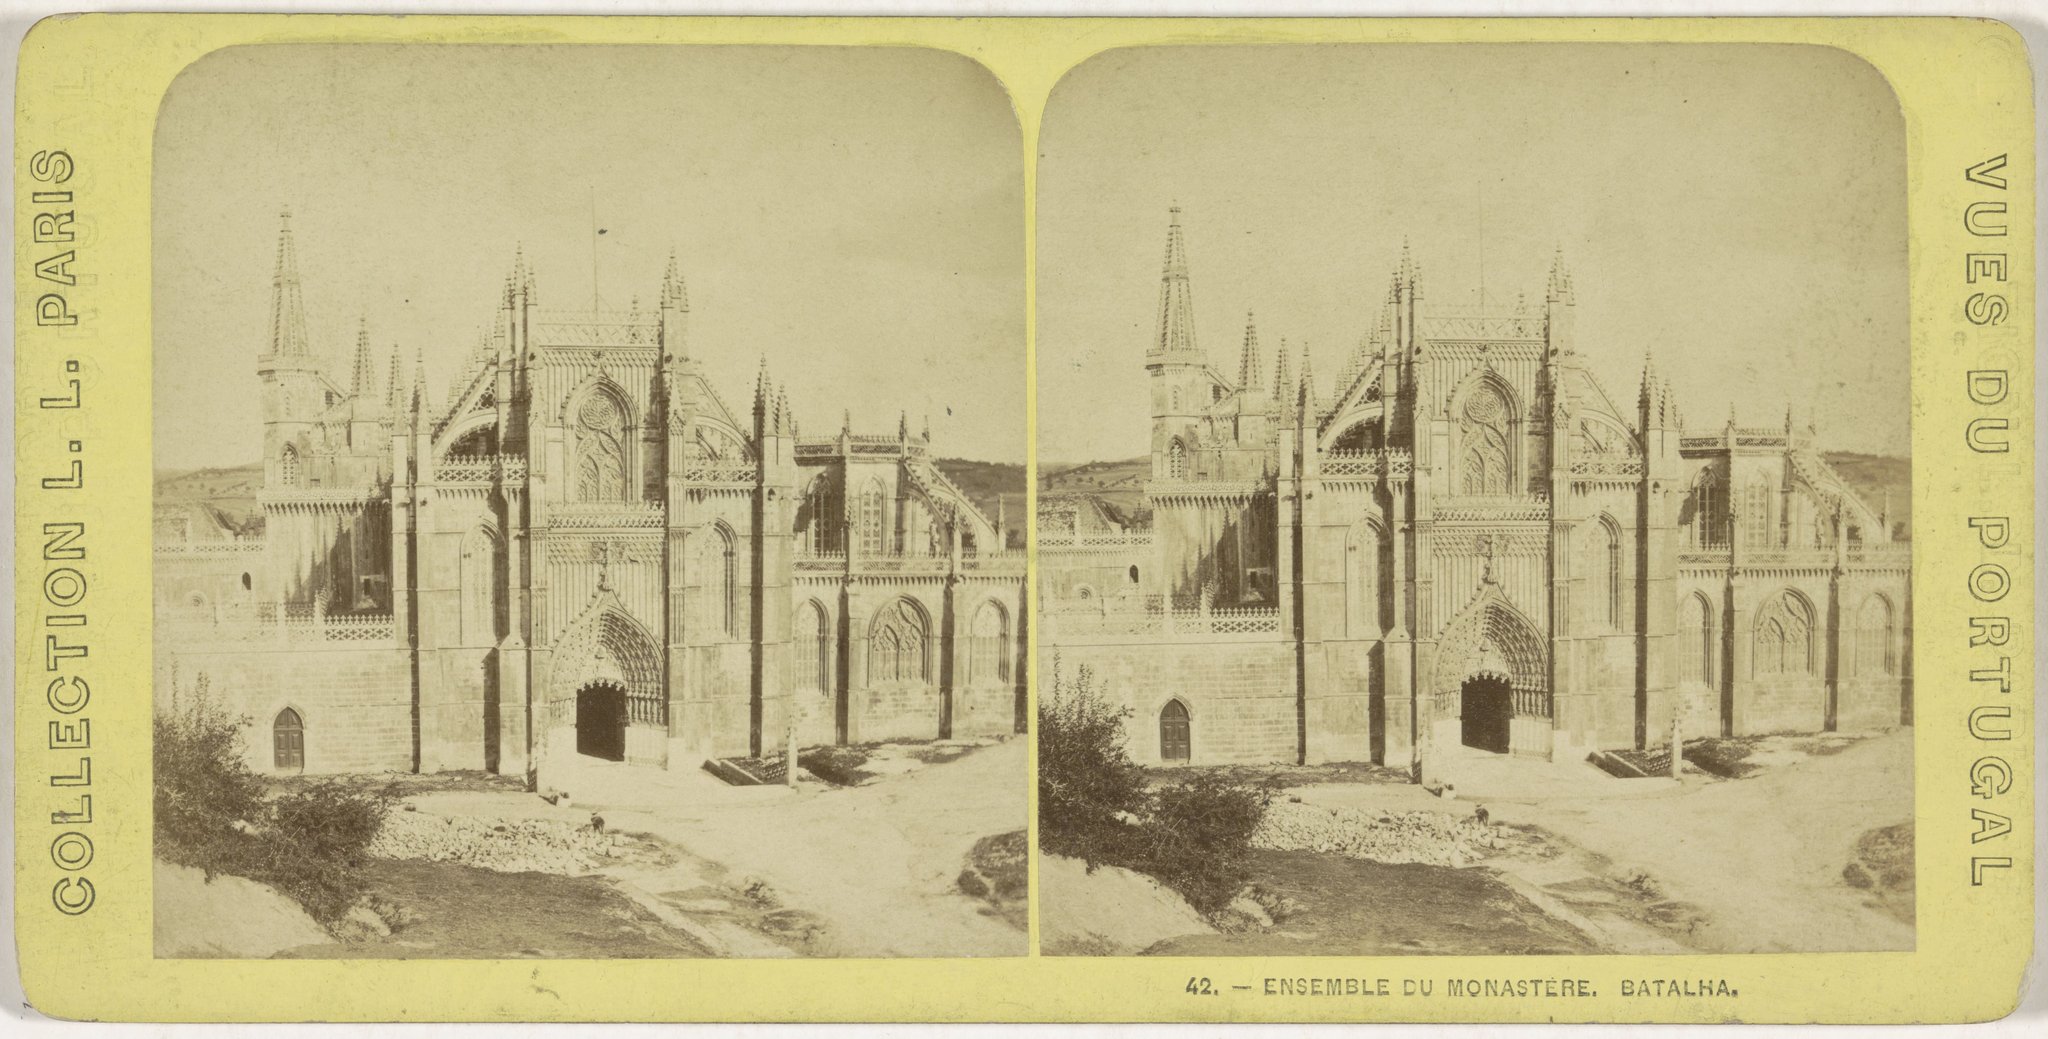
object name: stereograph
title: Ensemble du Monastere, Batalha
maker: Anonymous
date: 1868-1890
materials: cardboard, paper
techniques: albumen print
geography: batalha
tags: abbey, monastery, convent ~ roman catholic church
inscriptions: number: ‘42’